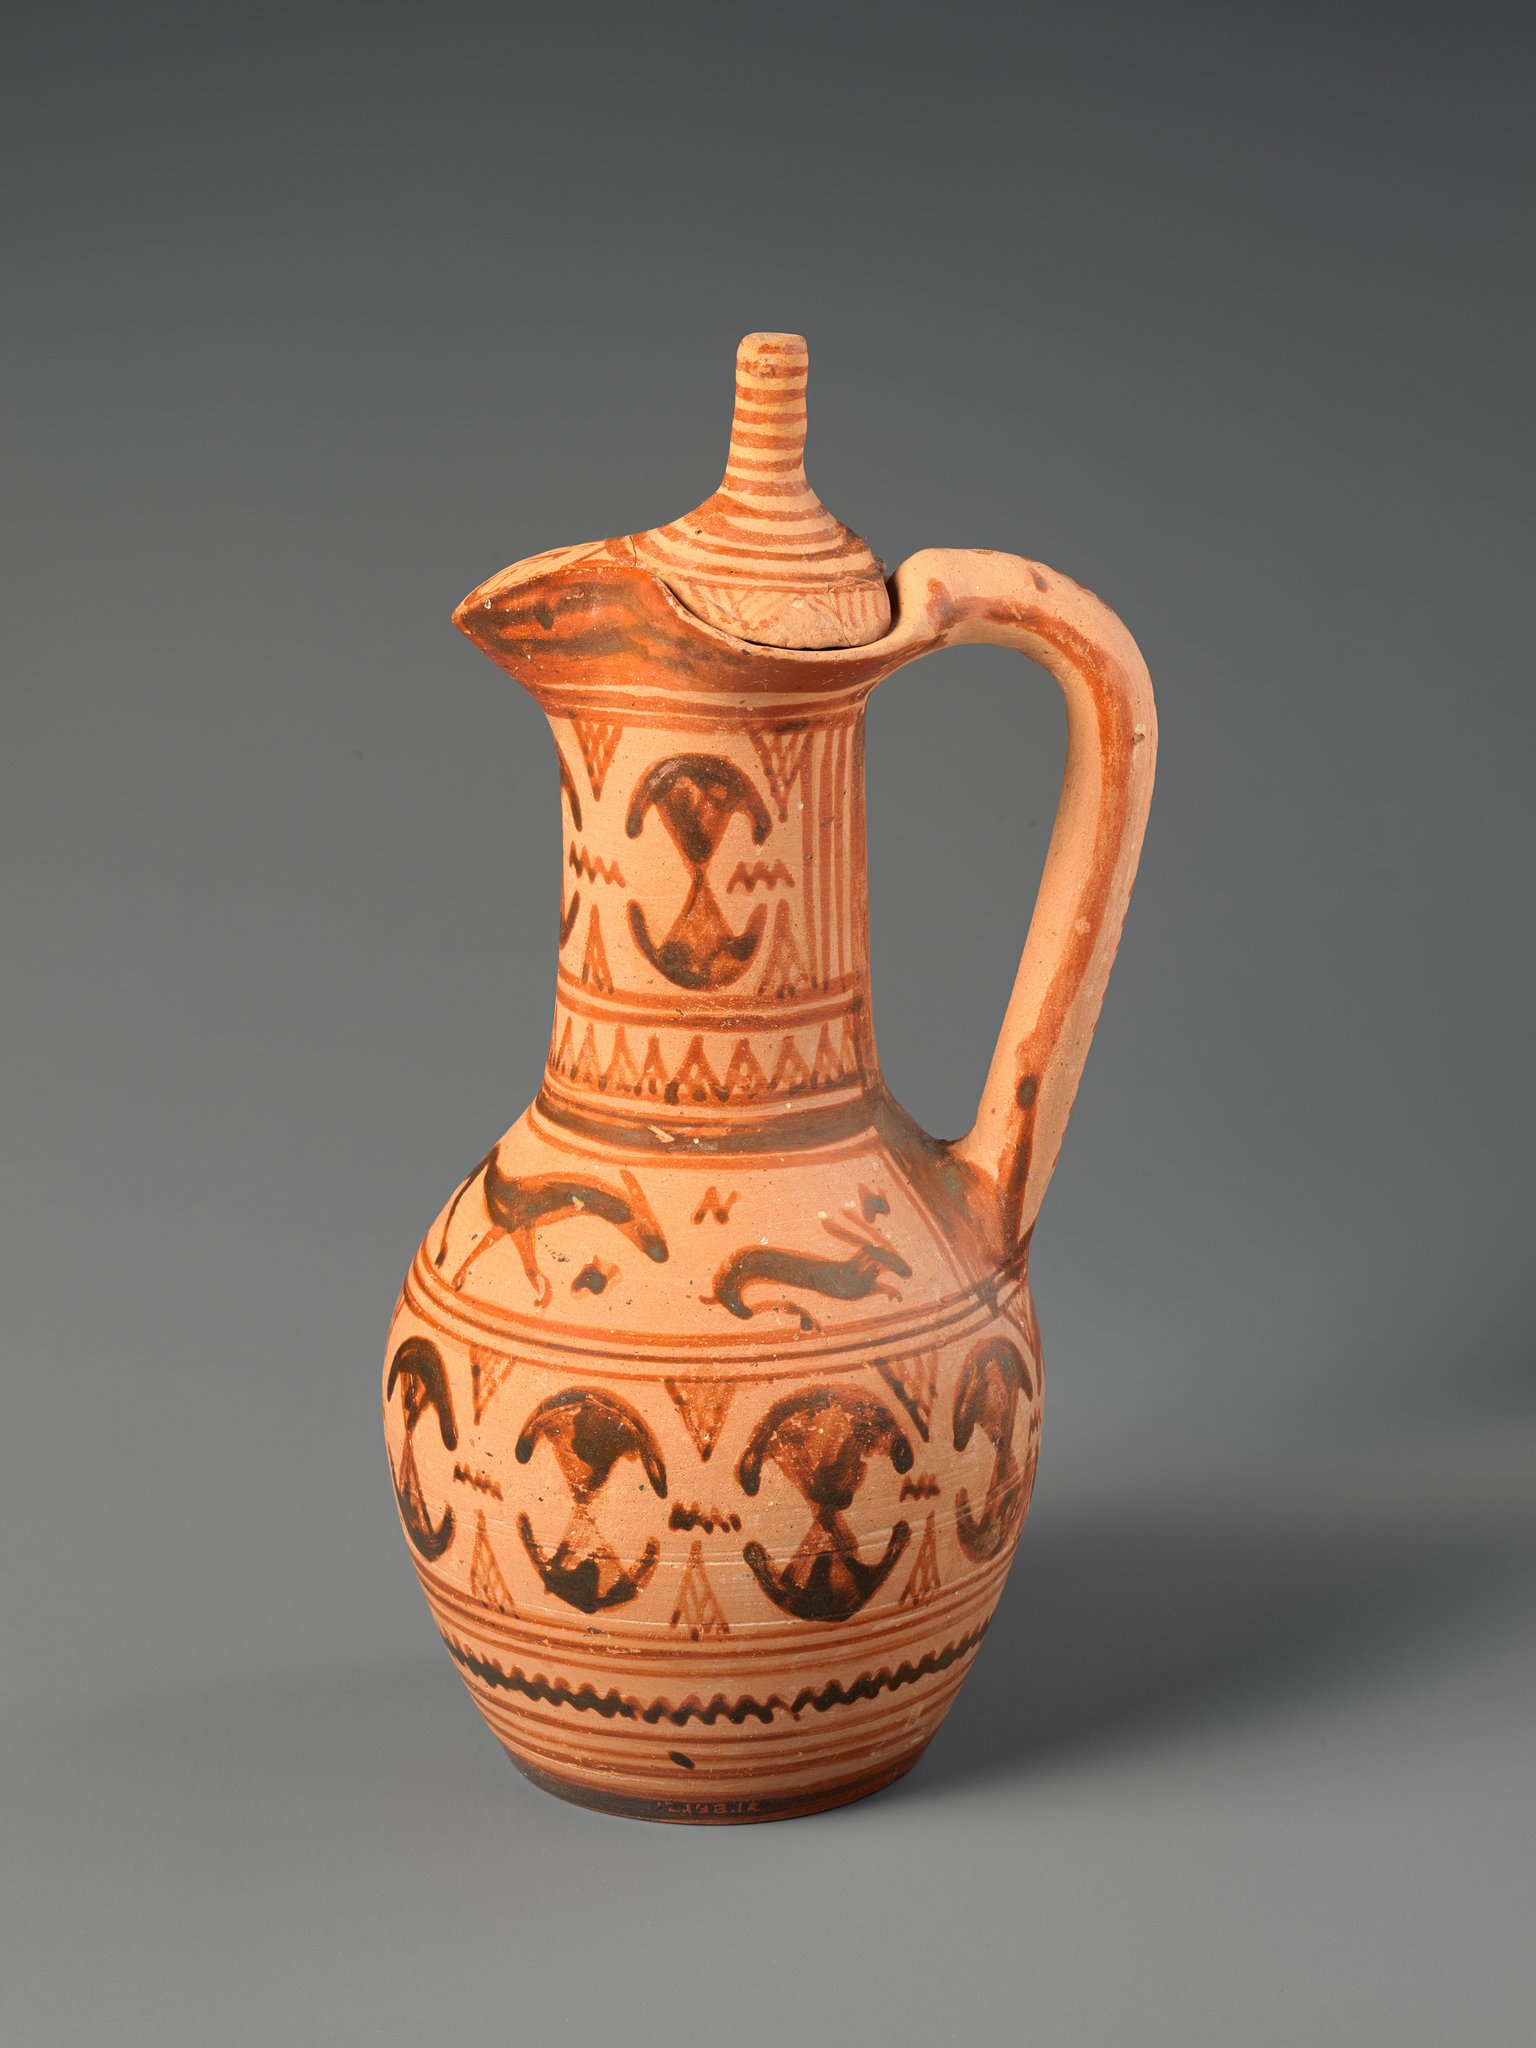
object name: oinochoe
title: Terracotta oinochoe (jug)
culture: greek, attic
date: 700 BCE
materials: terracotta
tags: animals